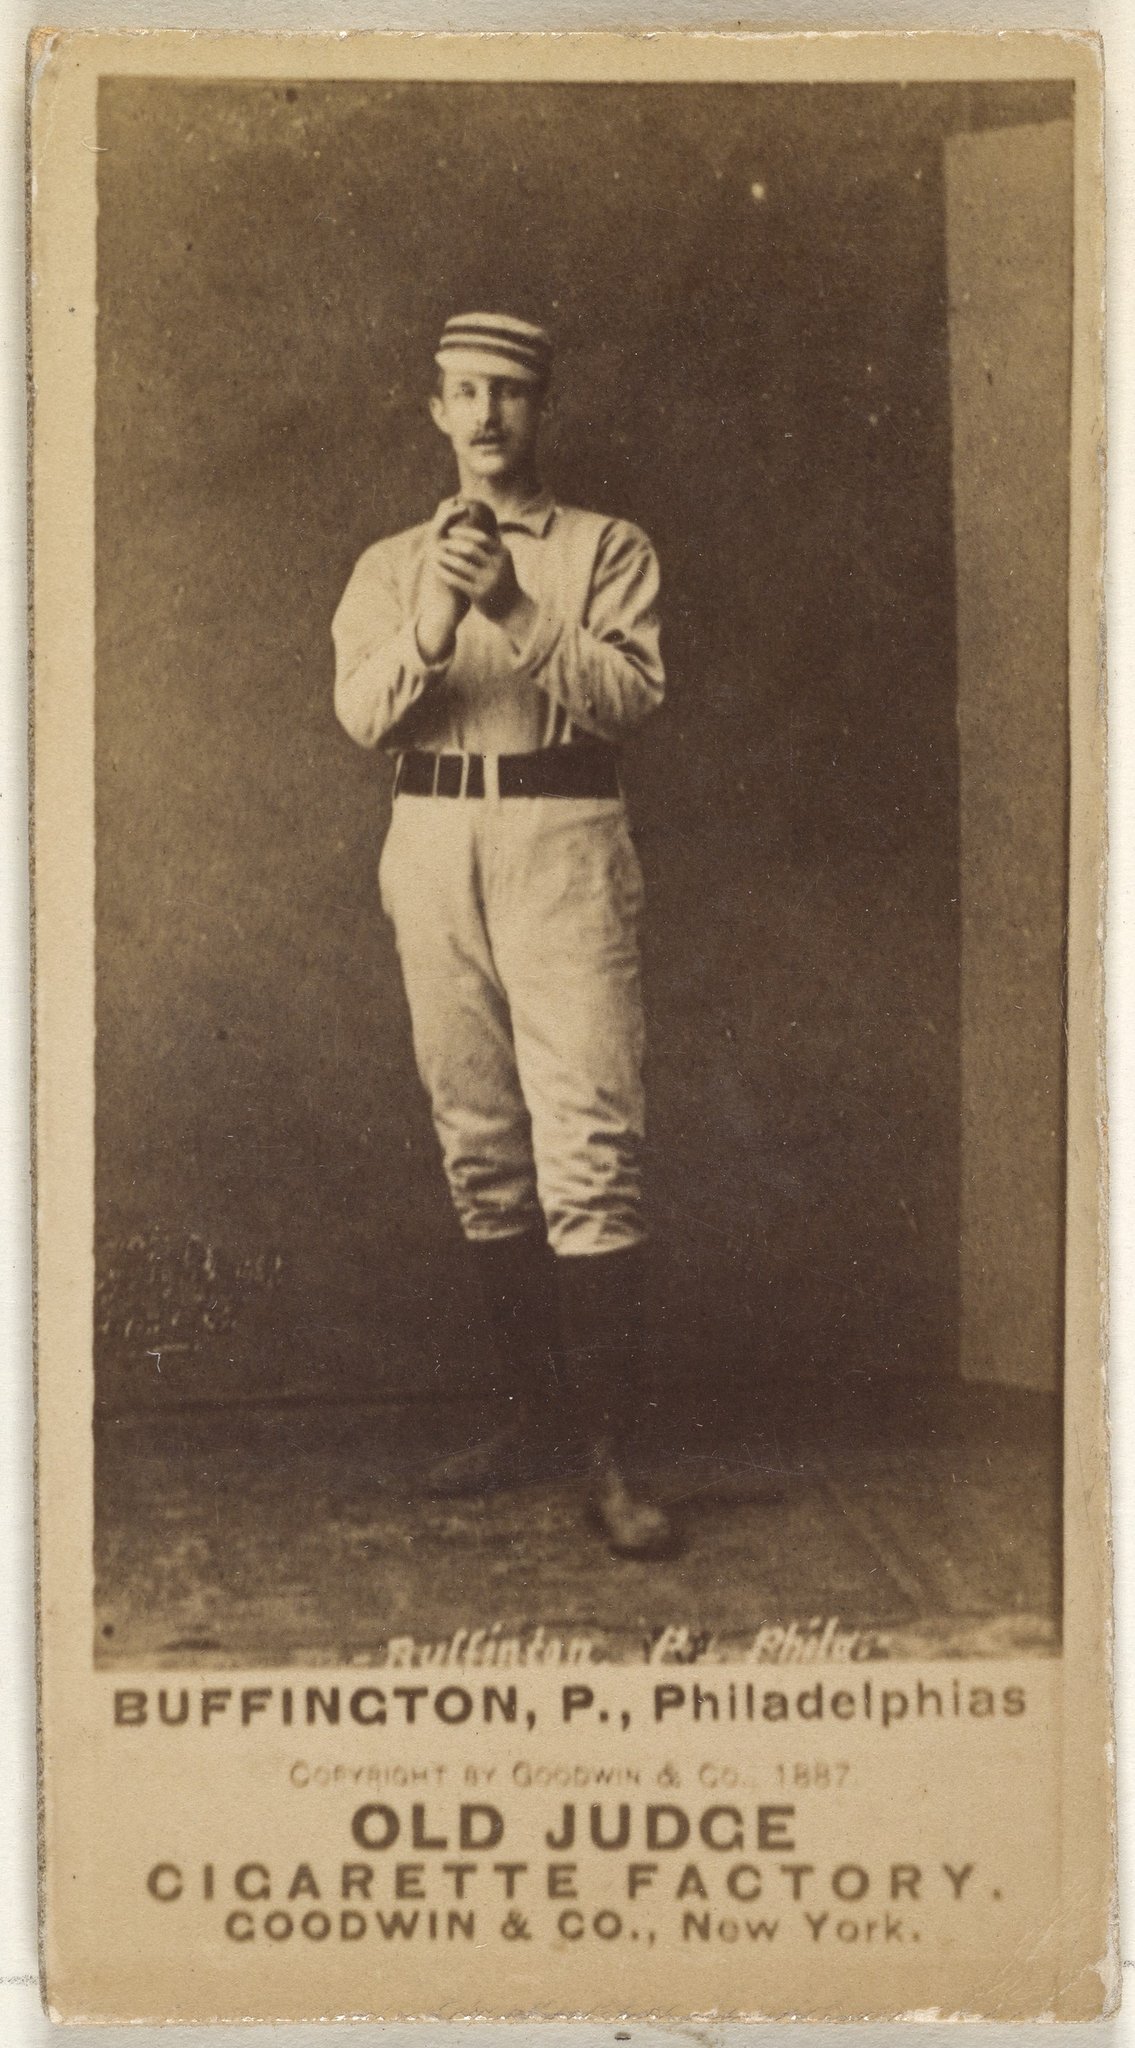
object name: baseball card, photograph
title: Charles G. Buffington, Center Field, Philadelphia, from the Old Judge series (N172) for Old Judge Cigarettes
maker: goodwin & company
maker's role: publisher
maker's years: 1850-1950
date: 1887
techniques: albumen silver print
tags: men,portraits,baseball,athletes